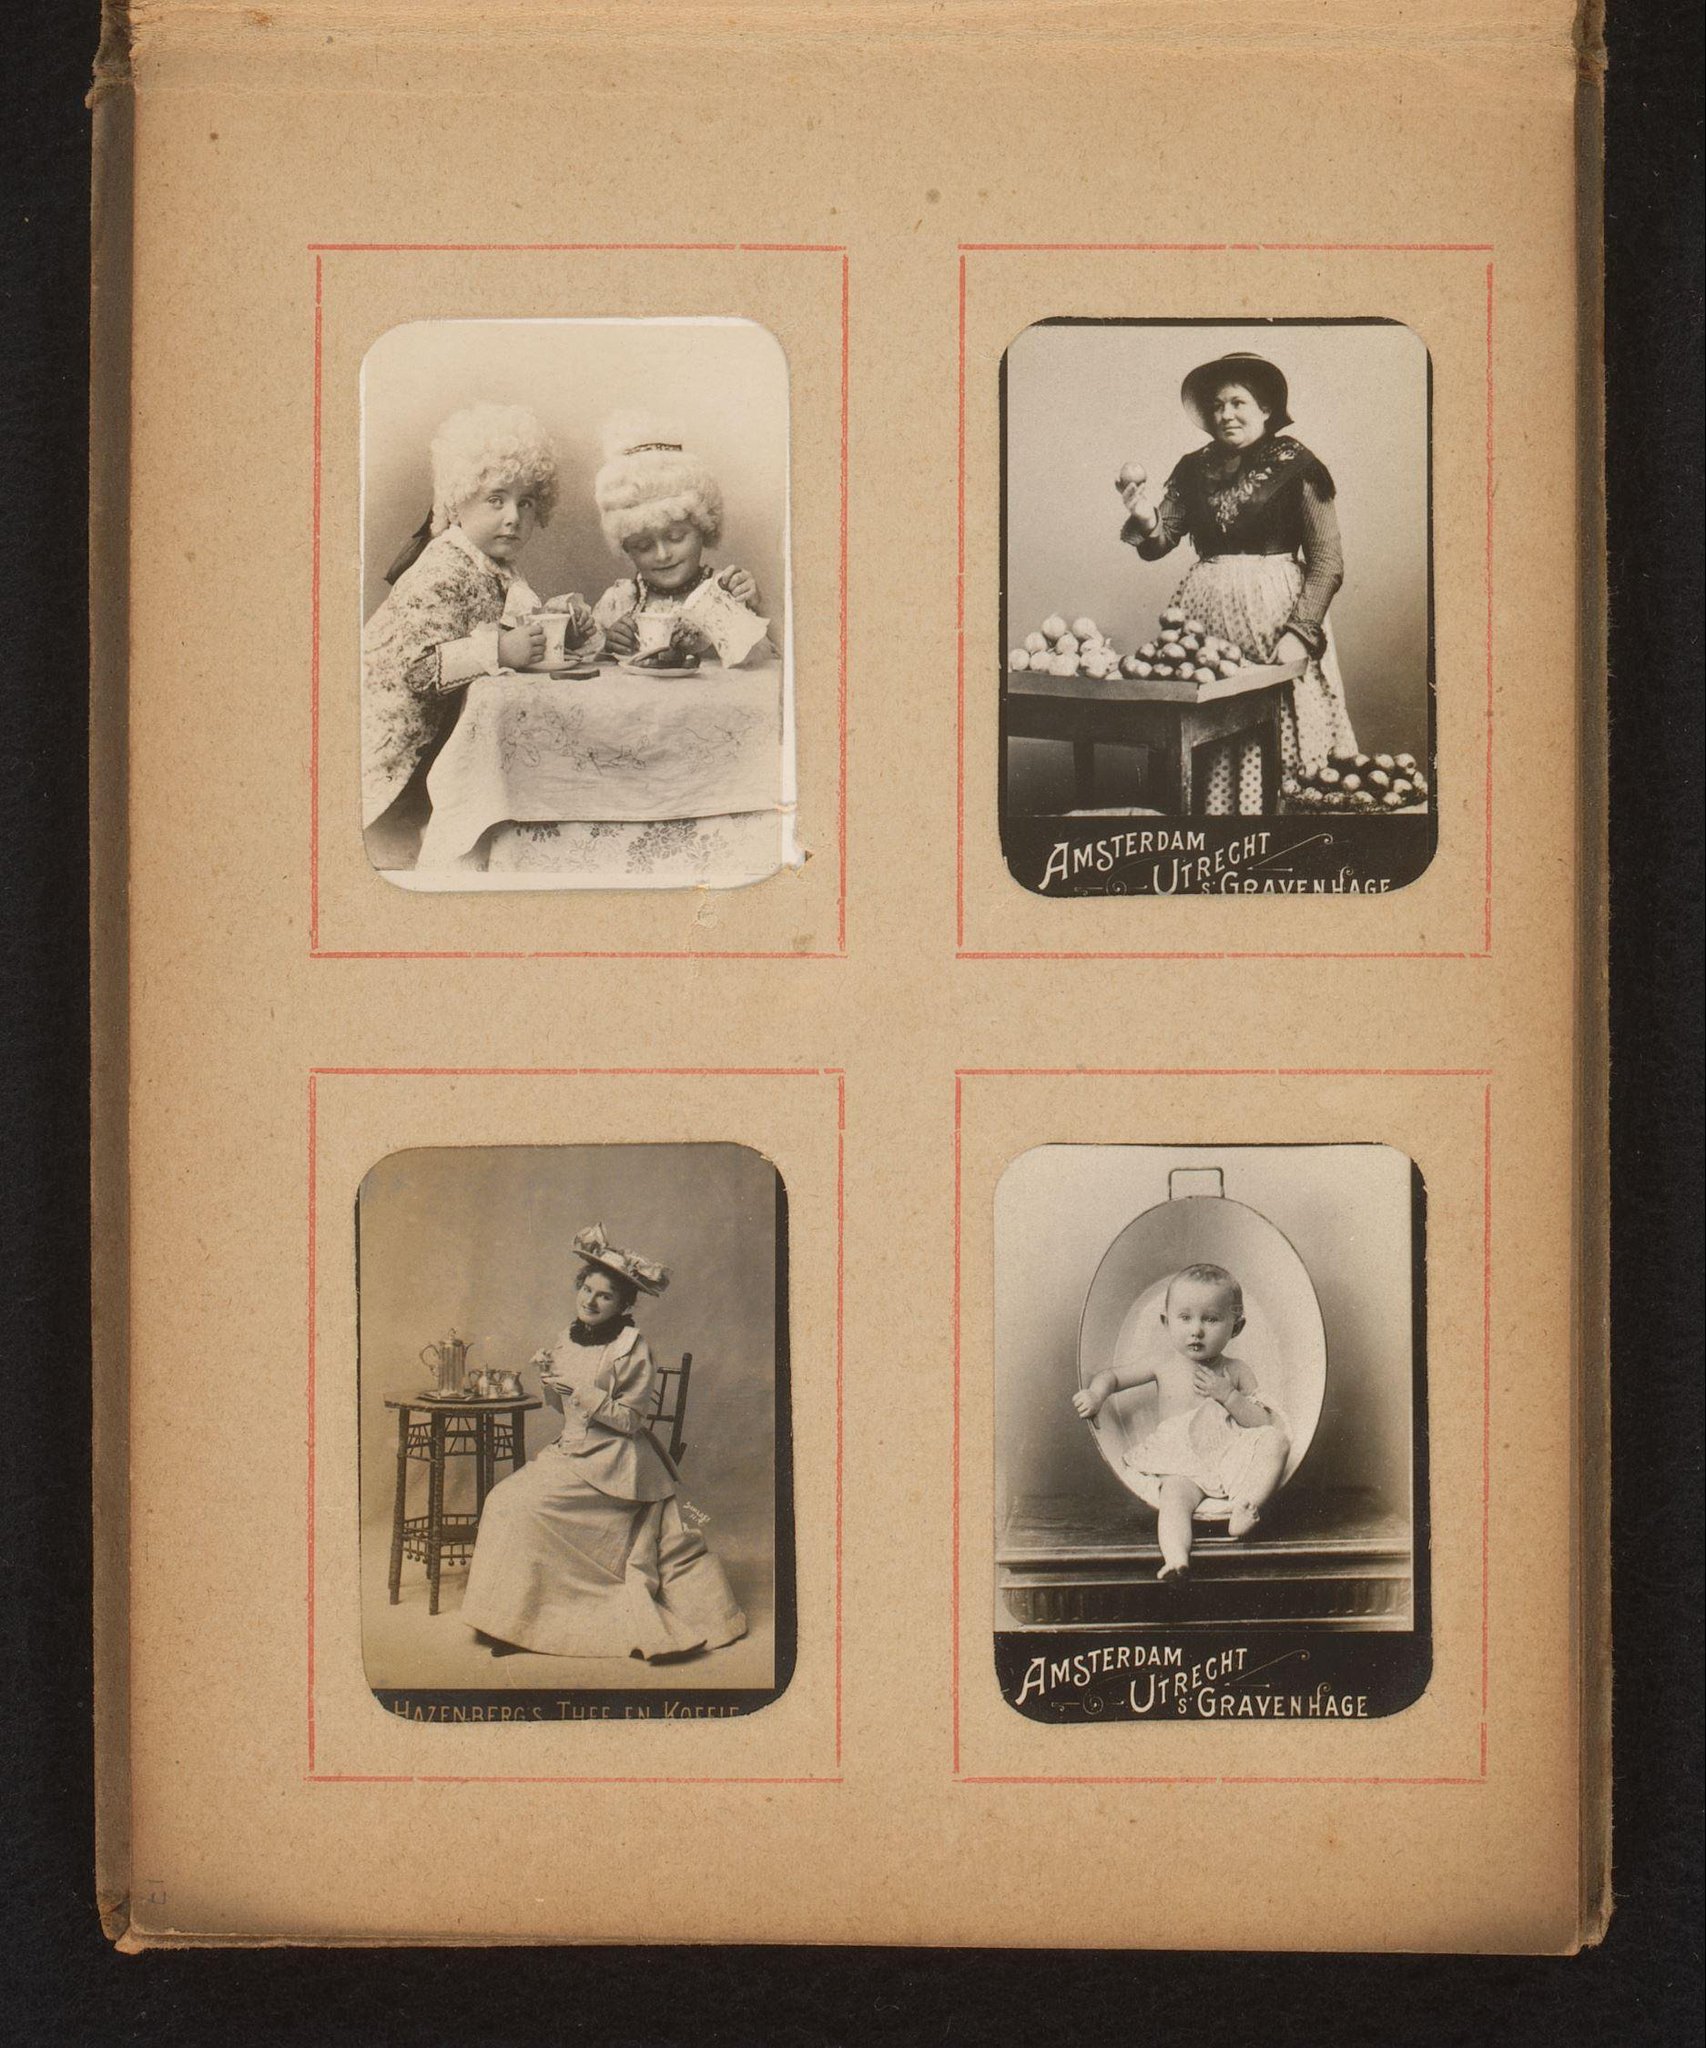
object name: album leaf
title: Portetten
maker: Anonymous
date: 1880-1920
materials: paper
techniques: gelatin silver print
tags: adolescent, young woman, maiden, adult woman, child, infant, baby, trade games, imitative games, imitating adults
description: Portret van twee kinderen met pruik, portret van een vrouw met appels, portret van een jonge vrouw en portret van een baby. Deze pagina maakt deel uit van een album.